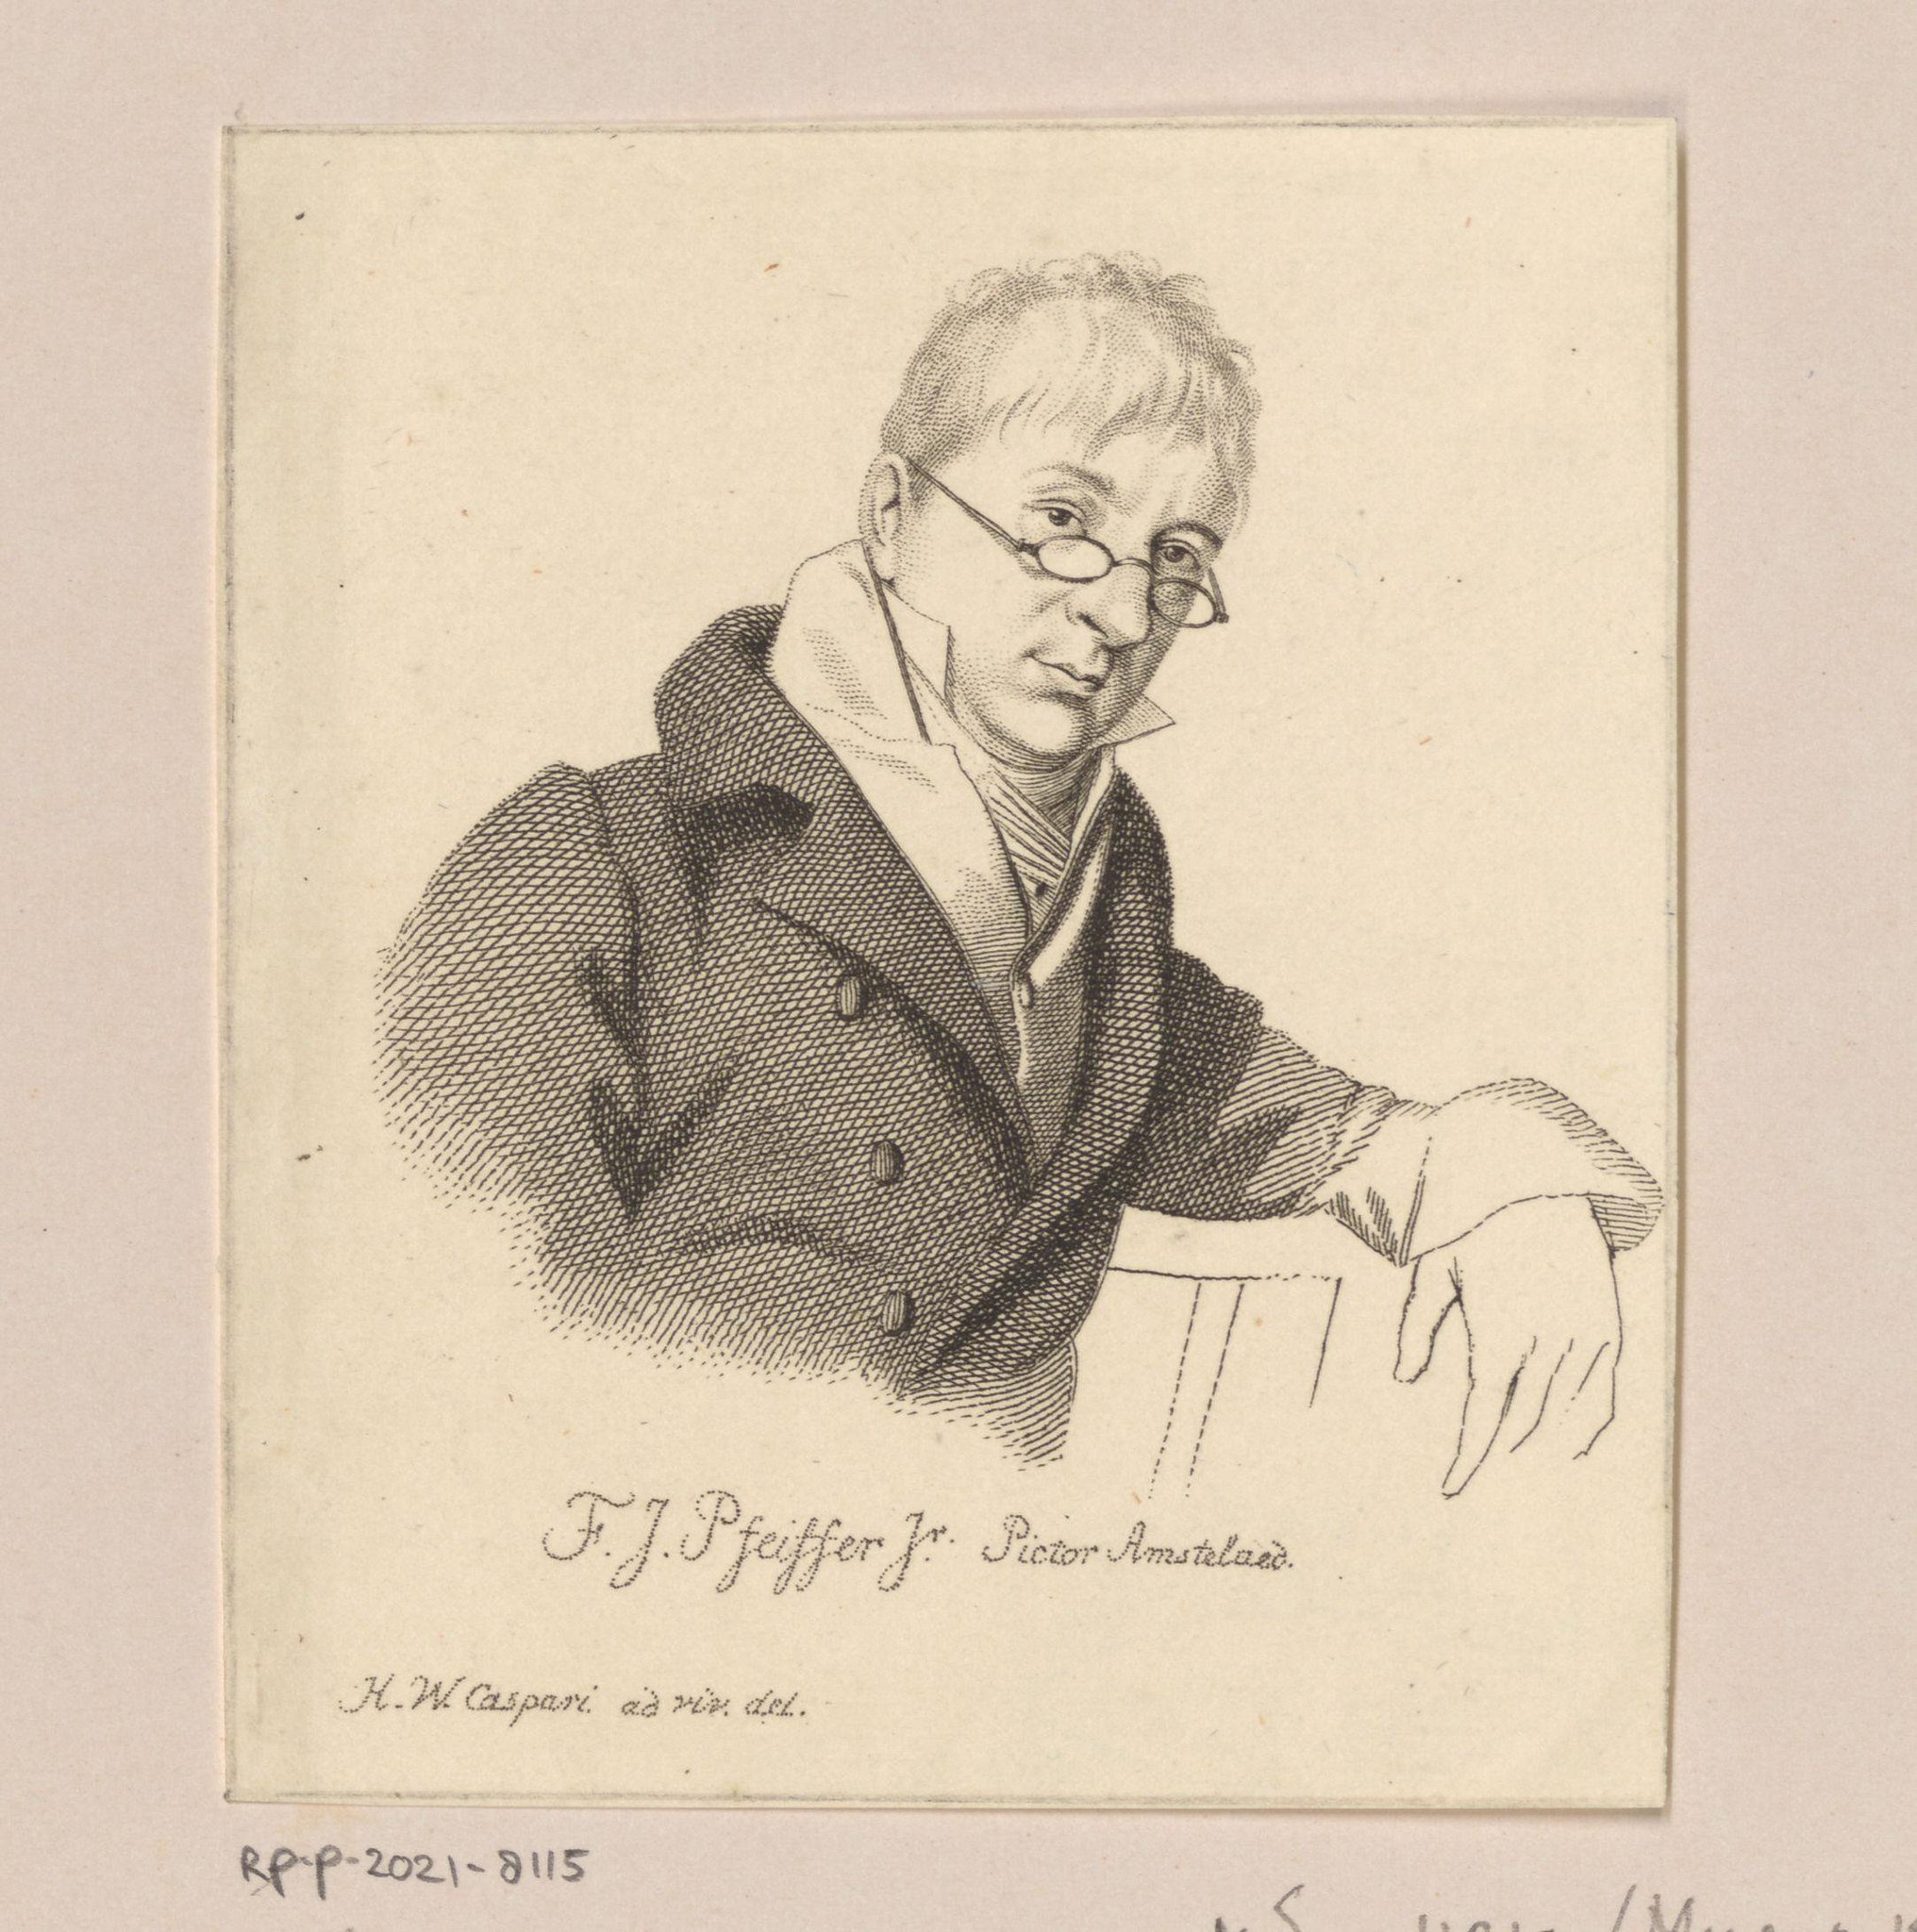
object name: print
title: Portret van François Joseph Pfeiffer II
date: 1815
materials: paper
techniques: engraving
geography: amsterdam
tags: liège, print maker, draughtsman, françois joseph pfeiffer (ii), eyeglasses, spectacles, adult man, historical persons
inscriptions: collector's mark: Lugt 924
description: Het gaat om een afgesneden gedeelte van een prent waarop Pfeiffer samen met een leerling staat afgebeeld. Gehele prent gebruikt in: Jacob Ernst Marcus, Etudes gravées. Amsterdam: S. de Grebber, 1826.